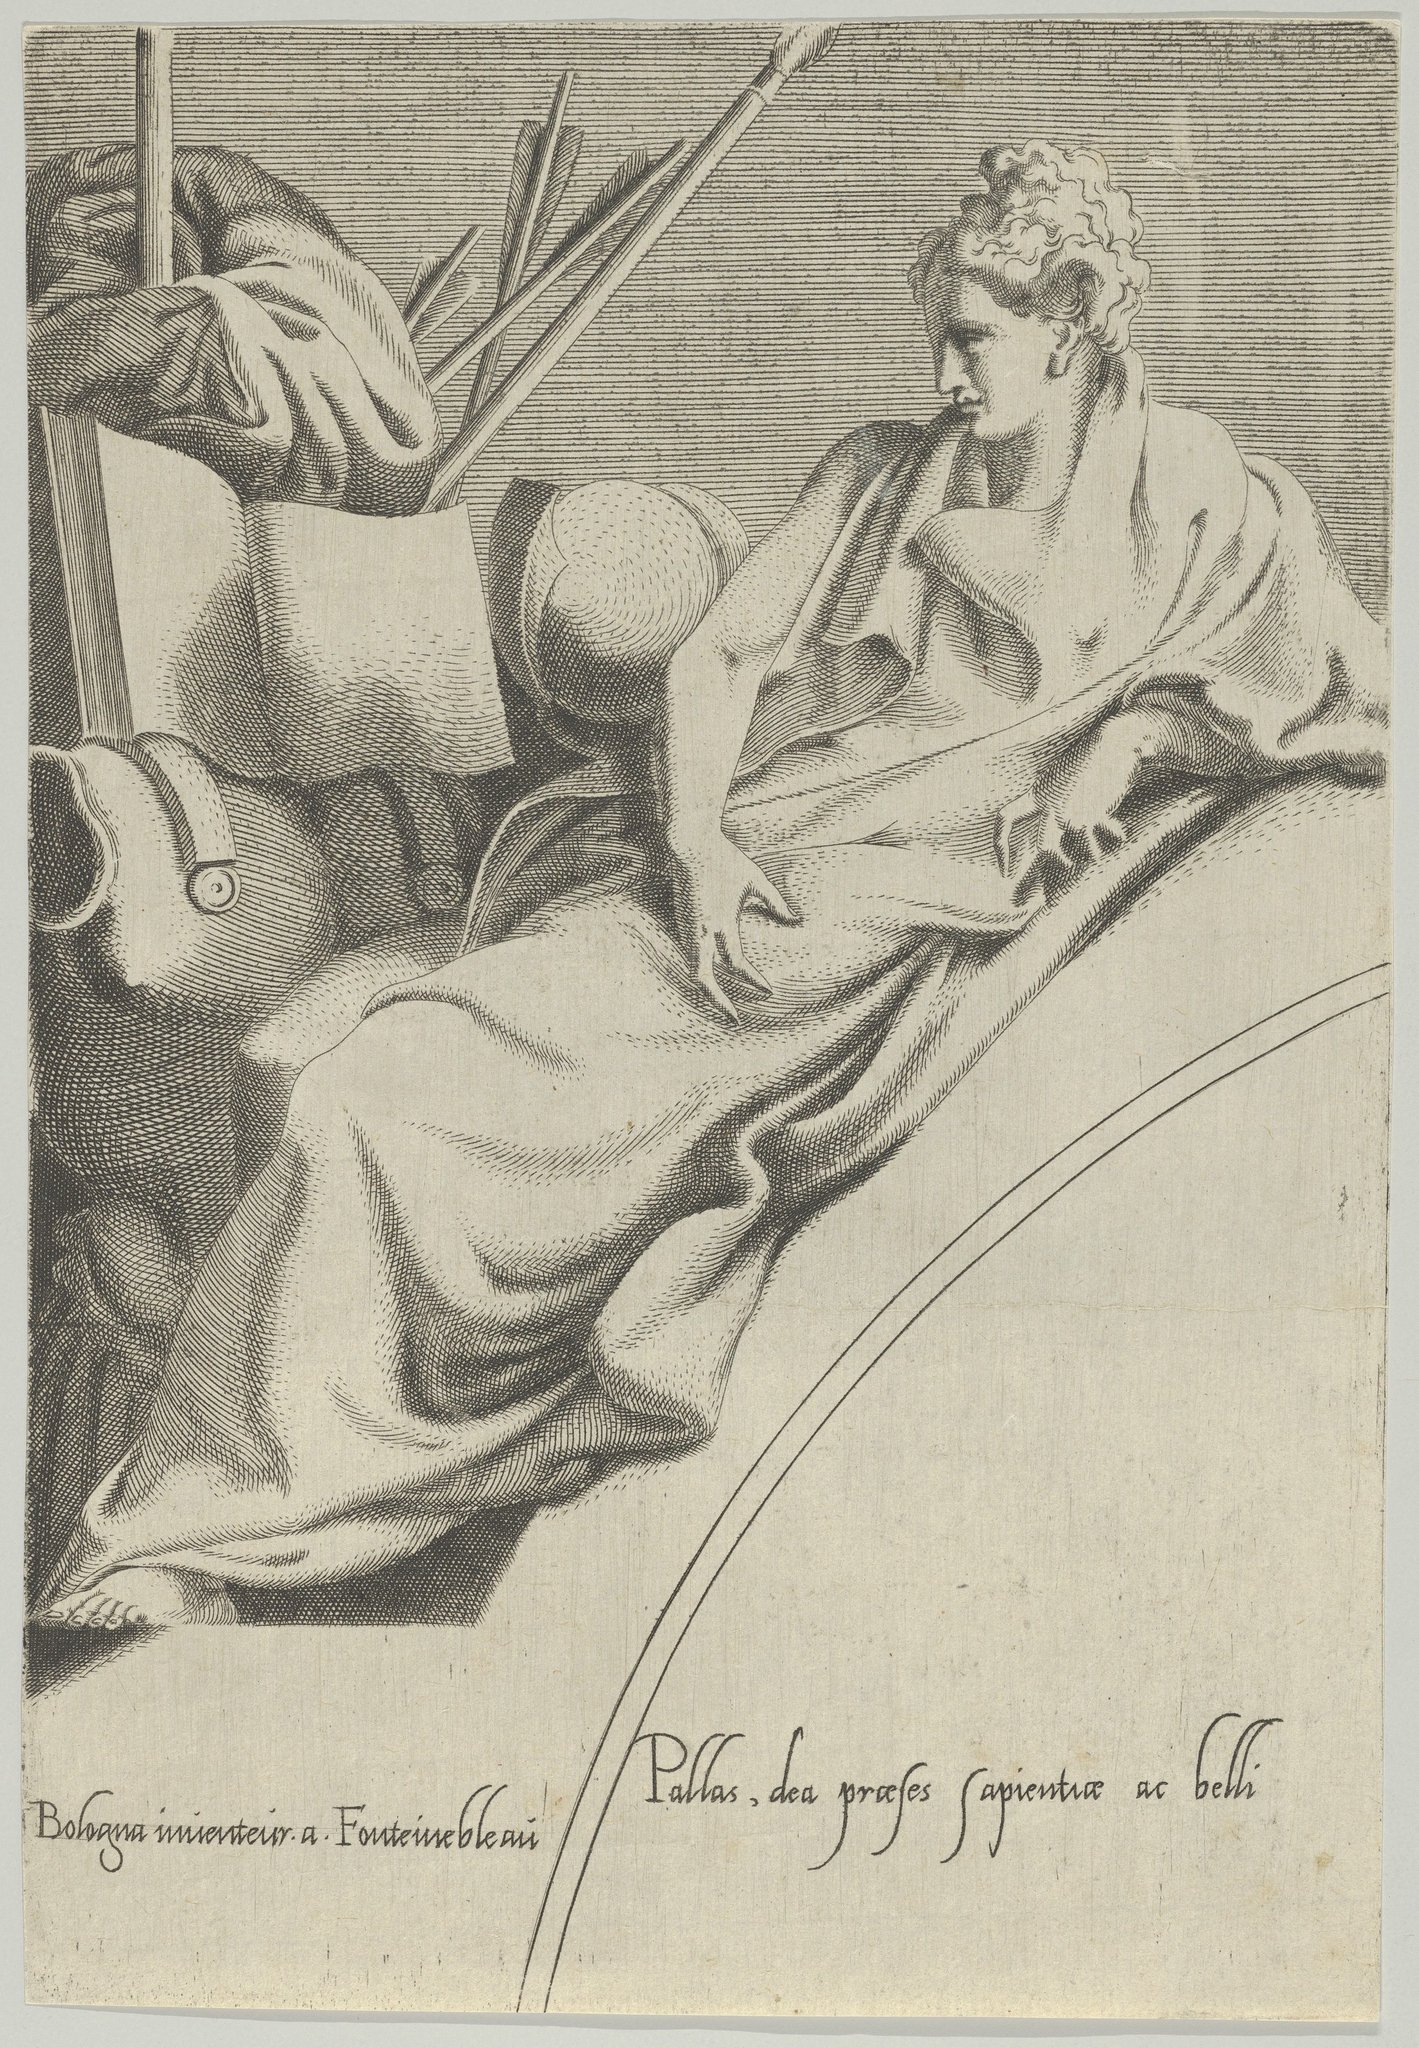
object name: print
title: Athena, from "The Muses and the Three Goddesses"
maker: anonymous, italian, 16th century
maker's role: artist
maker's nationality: italian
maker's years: 1550-1600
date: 1540-1545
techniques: engraving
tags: athena